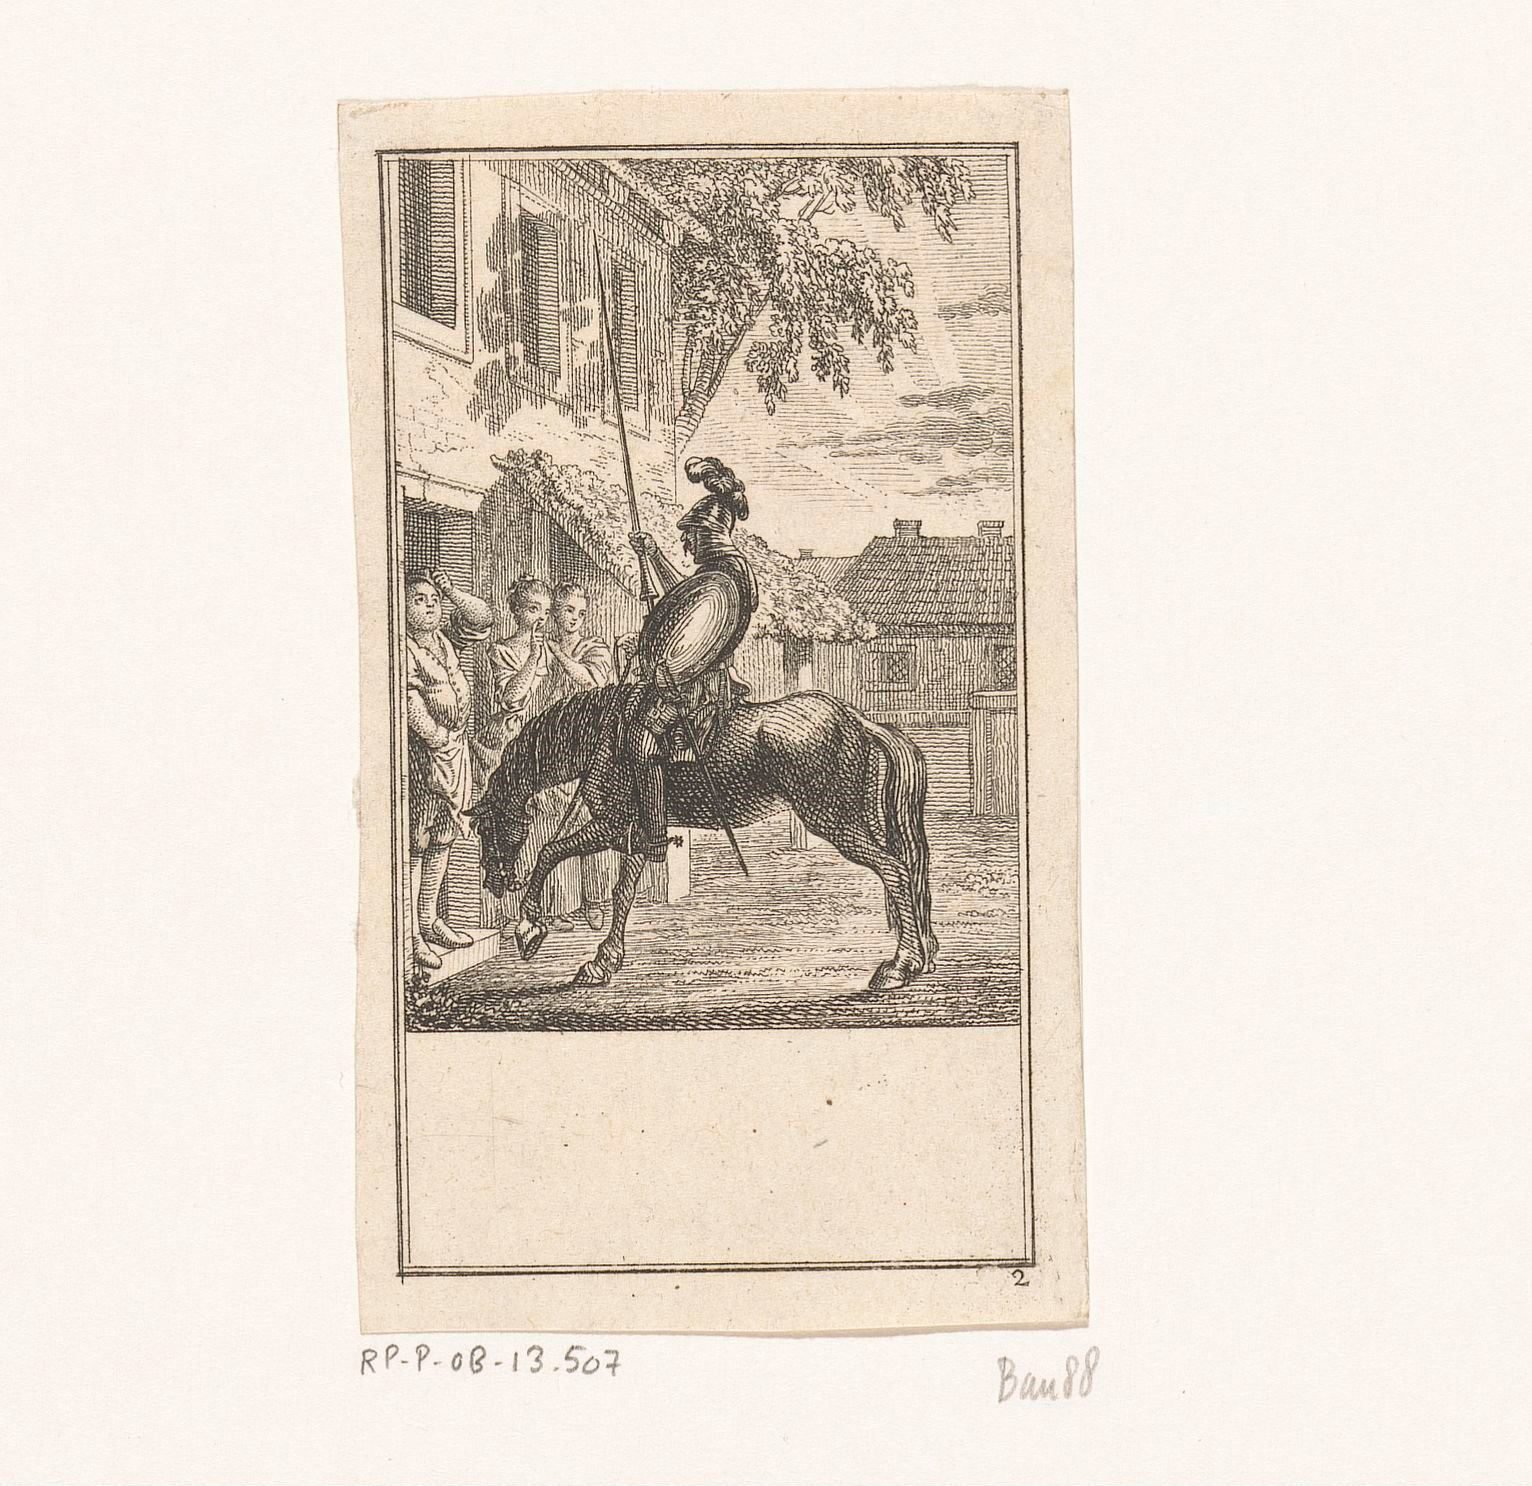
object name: print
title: Don Quichot voor de herberg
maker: daniel nikolaus chodowiecki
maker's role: draughtsman, print maker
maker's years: 1726-1801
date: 1770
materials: paper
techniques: etching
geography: berlin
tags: pavement, terrace in front of inn or restaurant, don quixote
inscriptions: collector's mark: Lugt 240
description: Deze prent maakt deel uit van een serie van twaalf scènes die het verhaal van Don Quichot door Miguel de Cervantes Saavedra illustreren. De scènes werden op een plaat geëtst. De tweede staat van deze serie werd ook gebruikt in: 'Almanac Genealogique pour l'an 1771'.